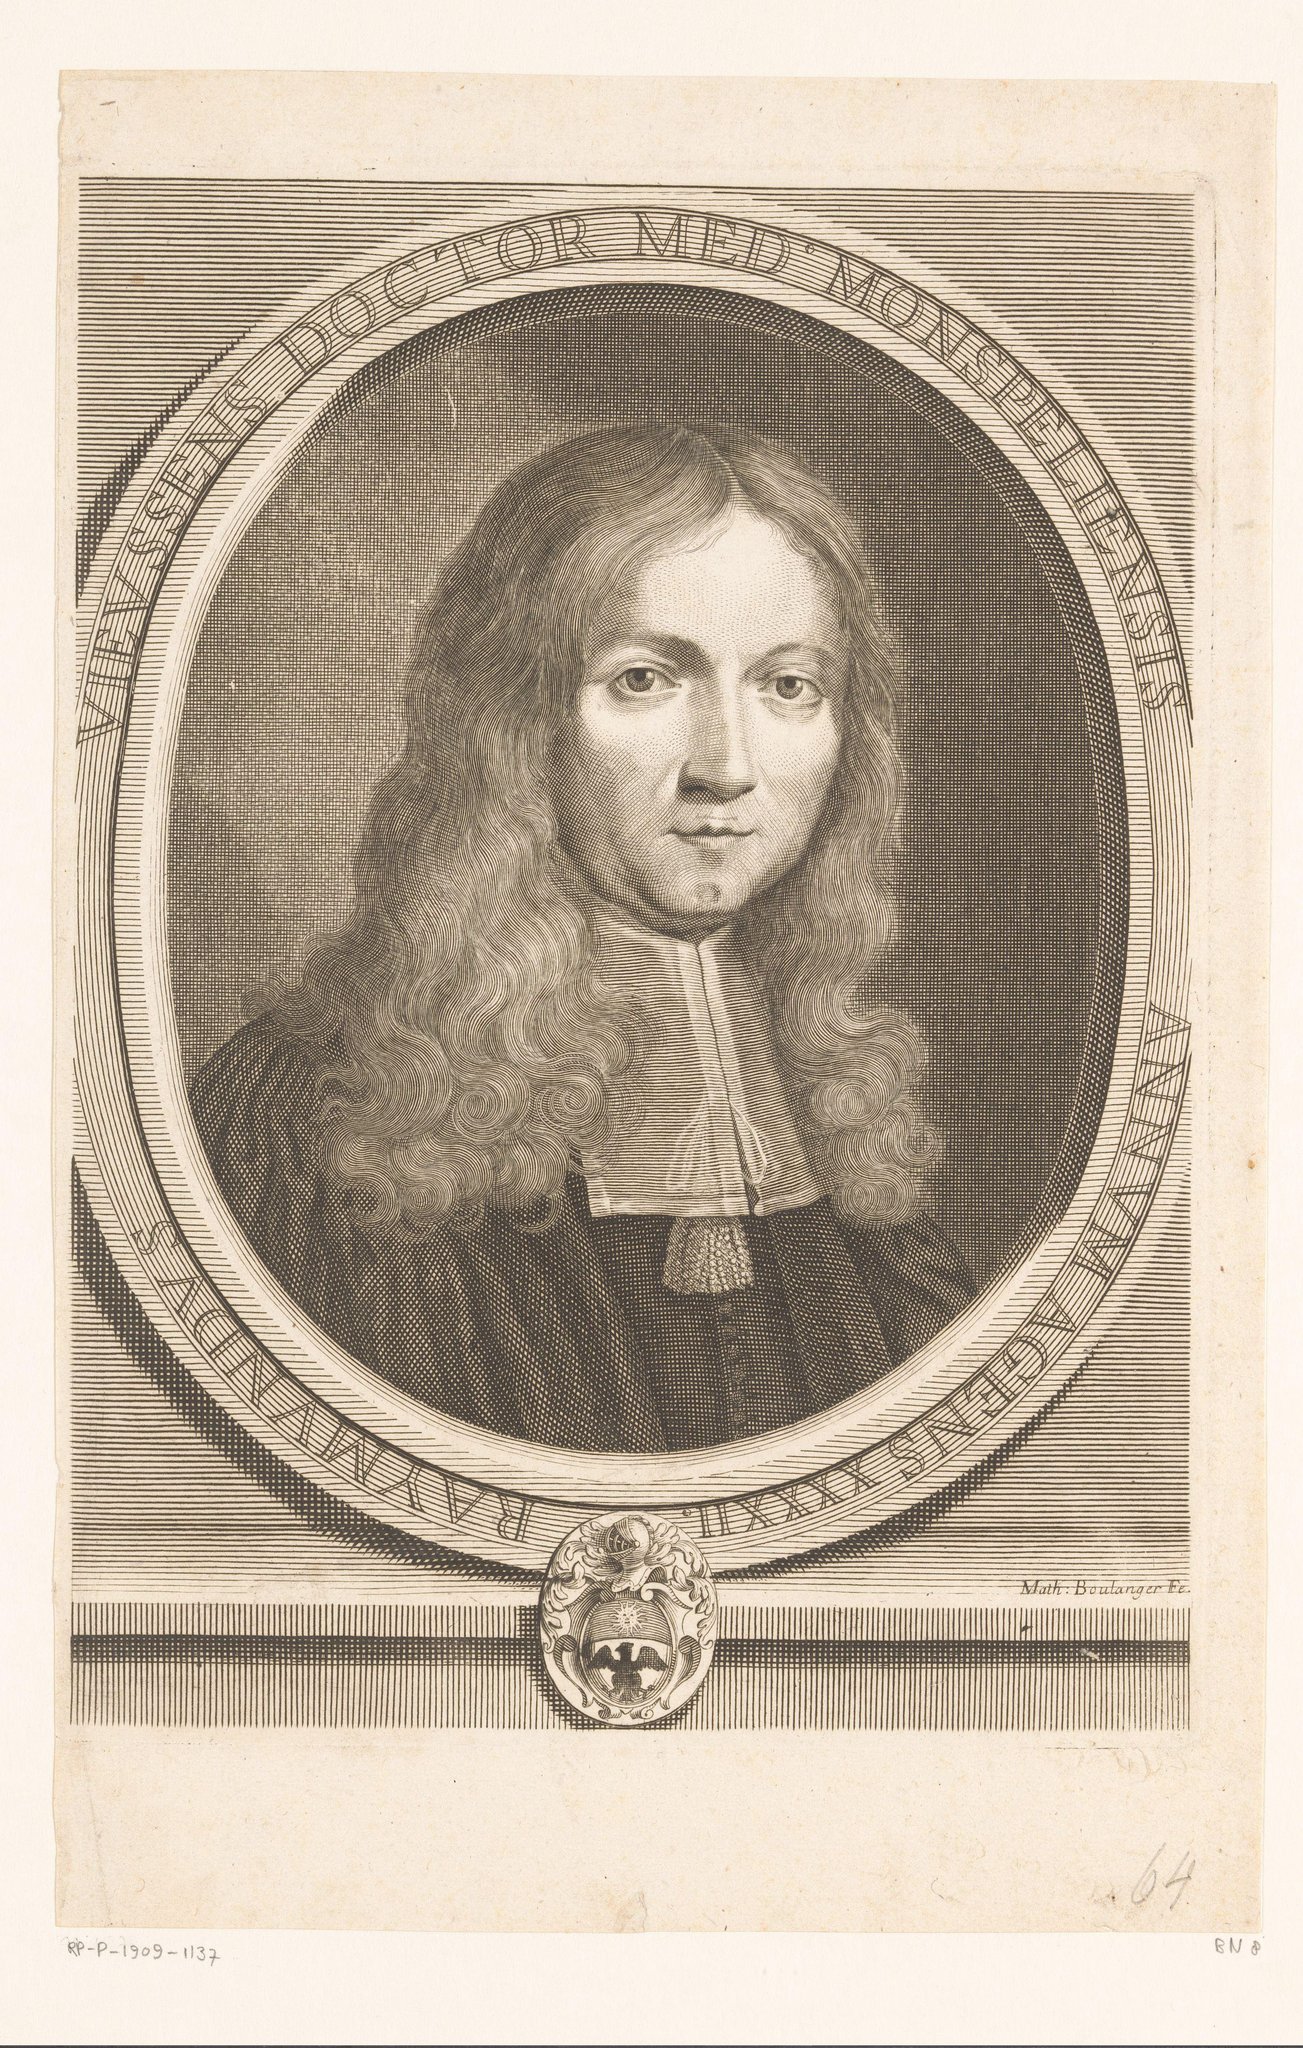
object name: print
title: Portret van Raymond Vieussens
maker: mathieu boulanger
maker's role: print maker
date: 1650-1699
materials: paper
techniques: engraving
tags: historical persons, physician, doctor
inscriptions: collector's mark: Lugt 2228